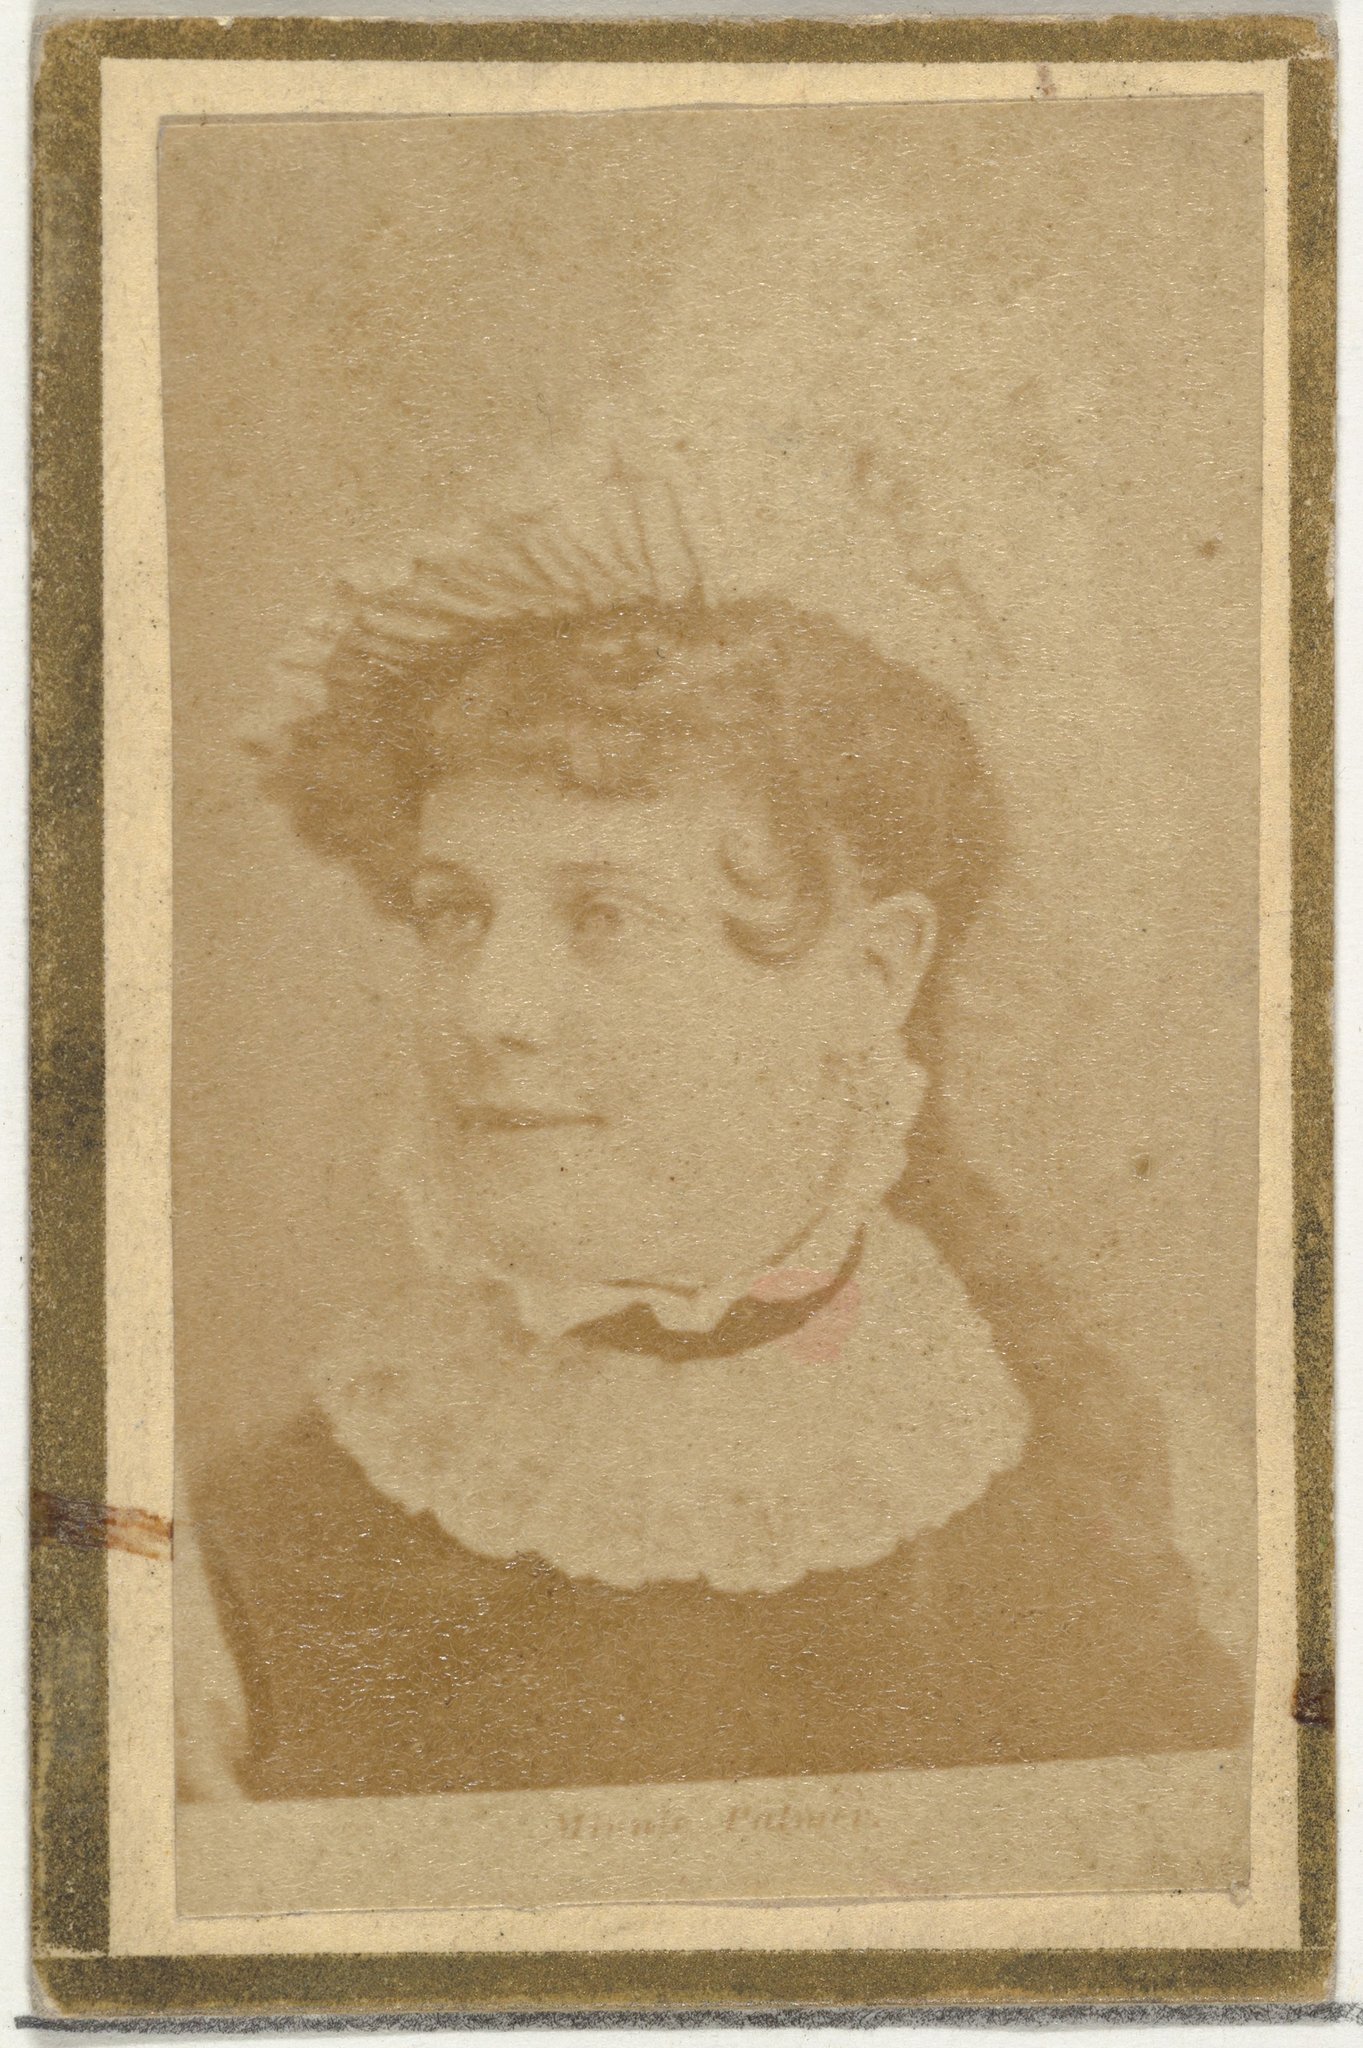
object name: photograph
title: Minnie Palmer, from the Actresses and Celebrities series (N60, Type 2) promoting Little Beauties Cigarettes for Allen & Ginter brand tobacco products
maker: allen & ginter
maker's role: publisher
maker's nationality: american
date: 1887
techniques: albumen silver print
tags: portraits,women,actresses